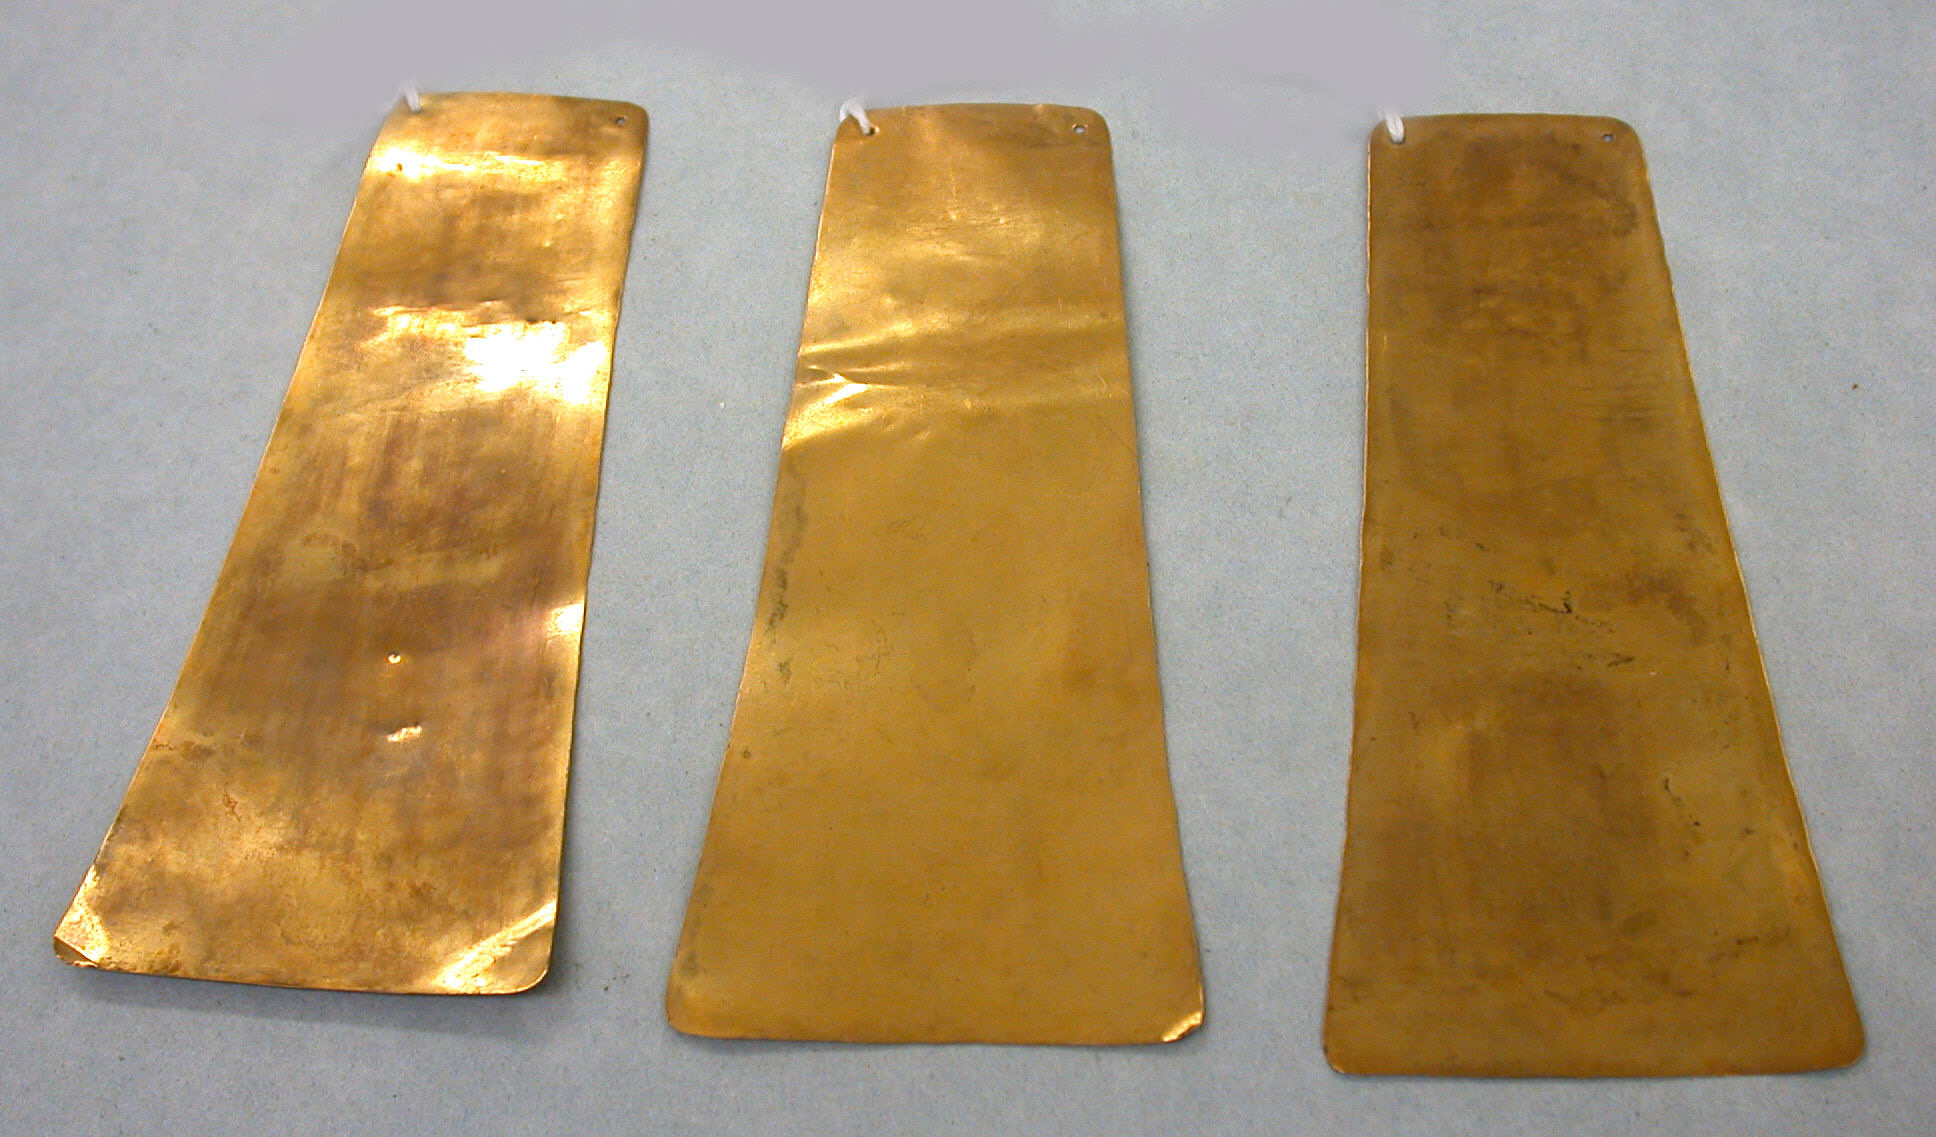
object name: ornament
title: Tab Ornament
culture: salinar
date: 100 BCE-200 CE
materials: gold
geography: peru